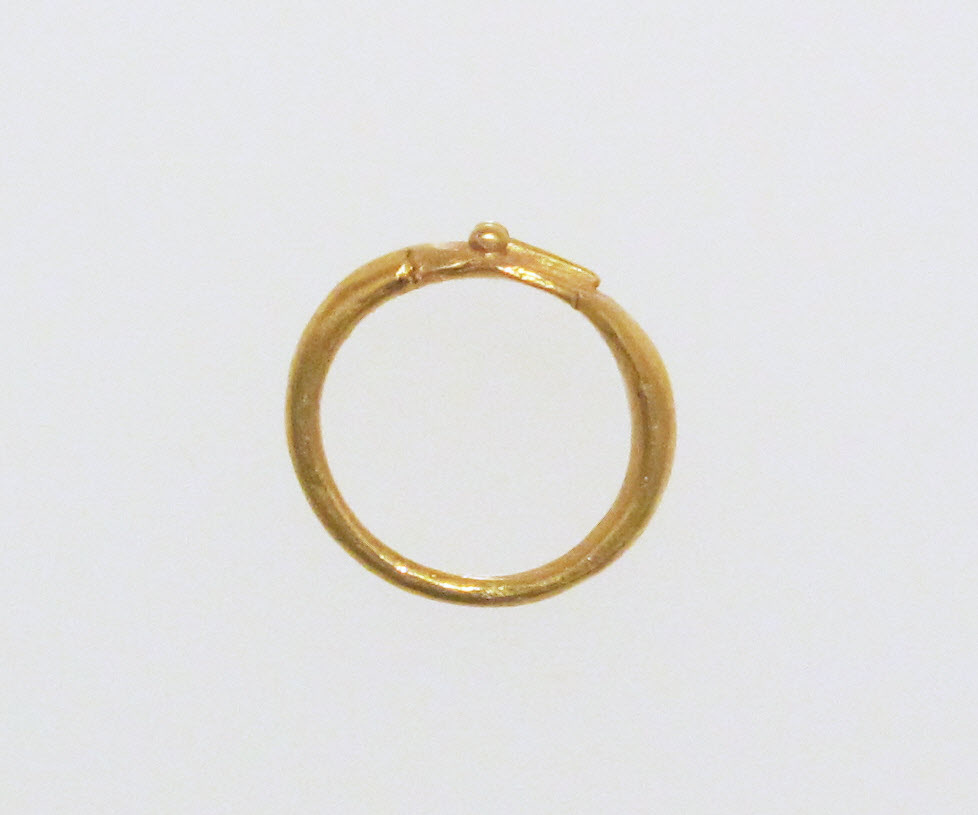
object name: ring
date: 7000 BCE-330 CE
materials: gold